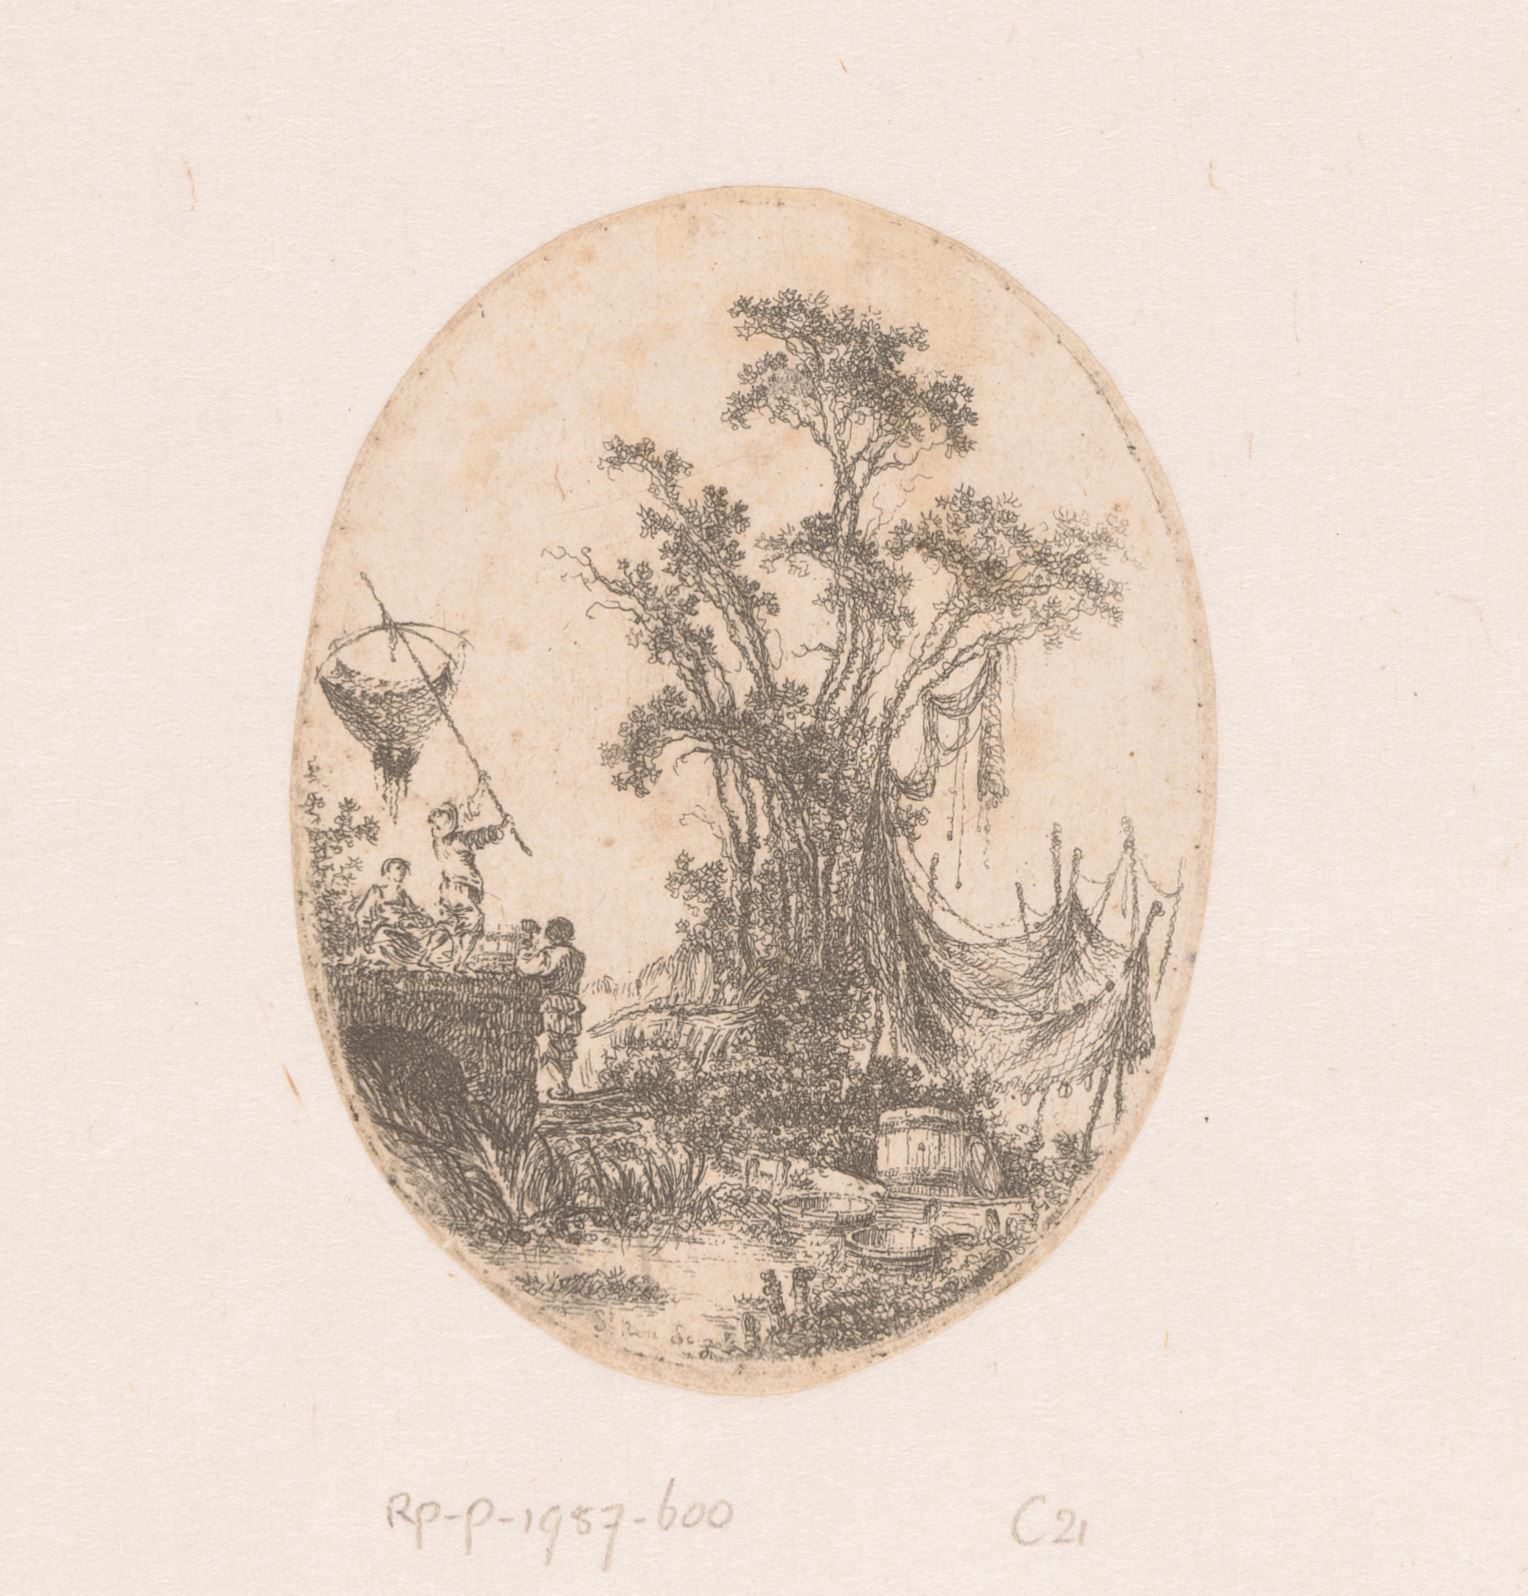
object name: print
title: Gezicht op een kleine rivier met daarin netten, links vissers aan het werk met een groot visnet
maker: richard de saint-non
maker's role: print maker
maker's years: 1727-1791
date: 1755-1760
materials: paper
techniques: etching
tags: fishing net, river, fisherman